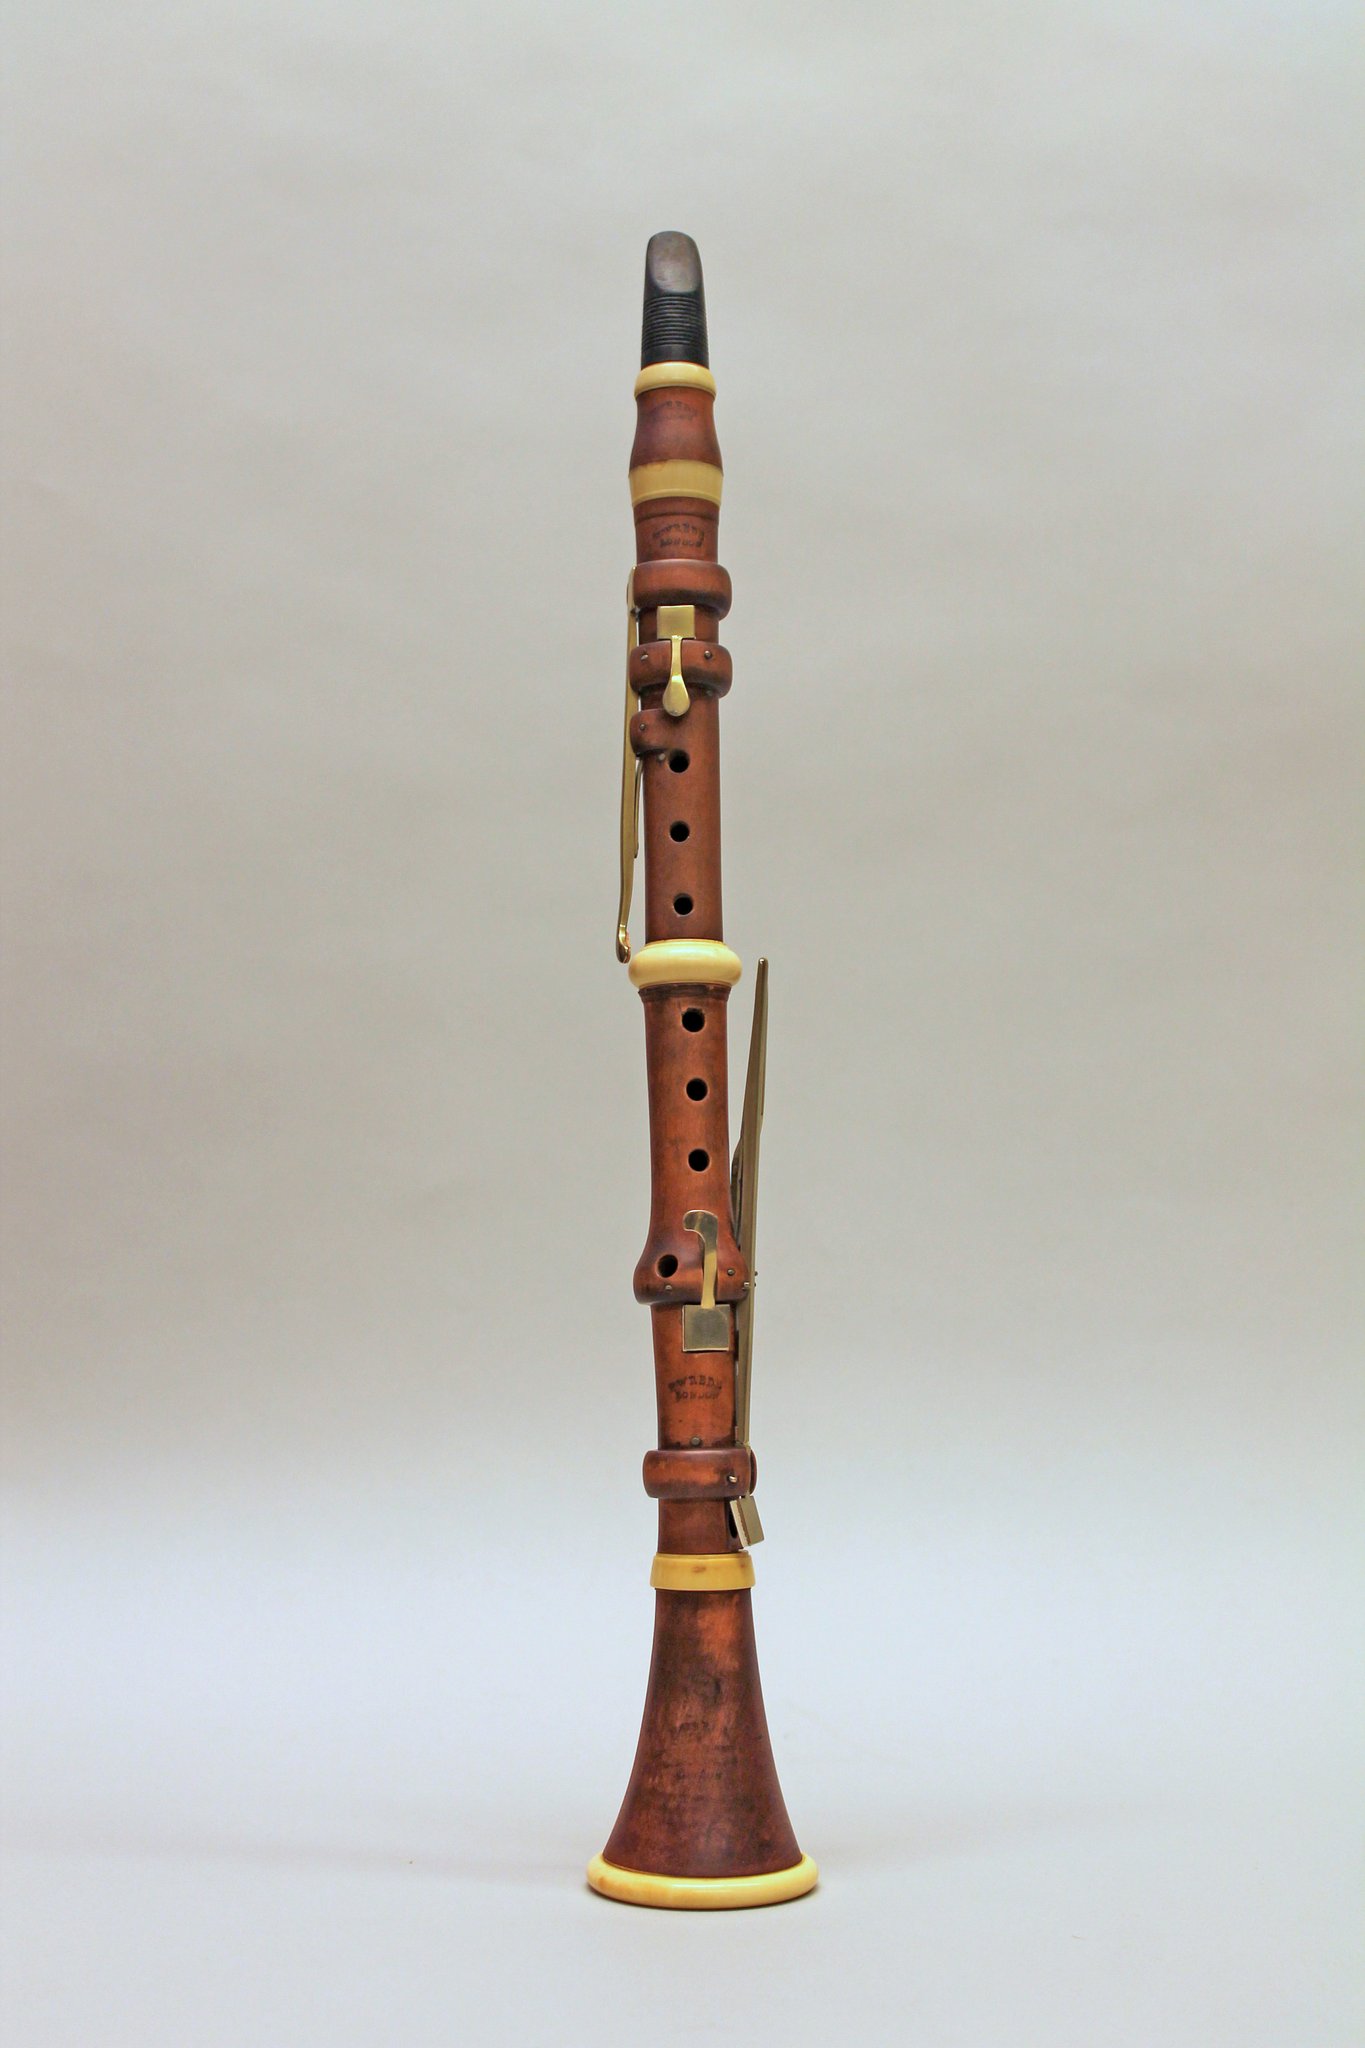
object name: clarinet in f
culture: british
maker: hermann wrede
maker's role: maker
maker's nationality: british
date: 1837-1840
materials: wood, brass, ivory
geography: united kingdom